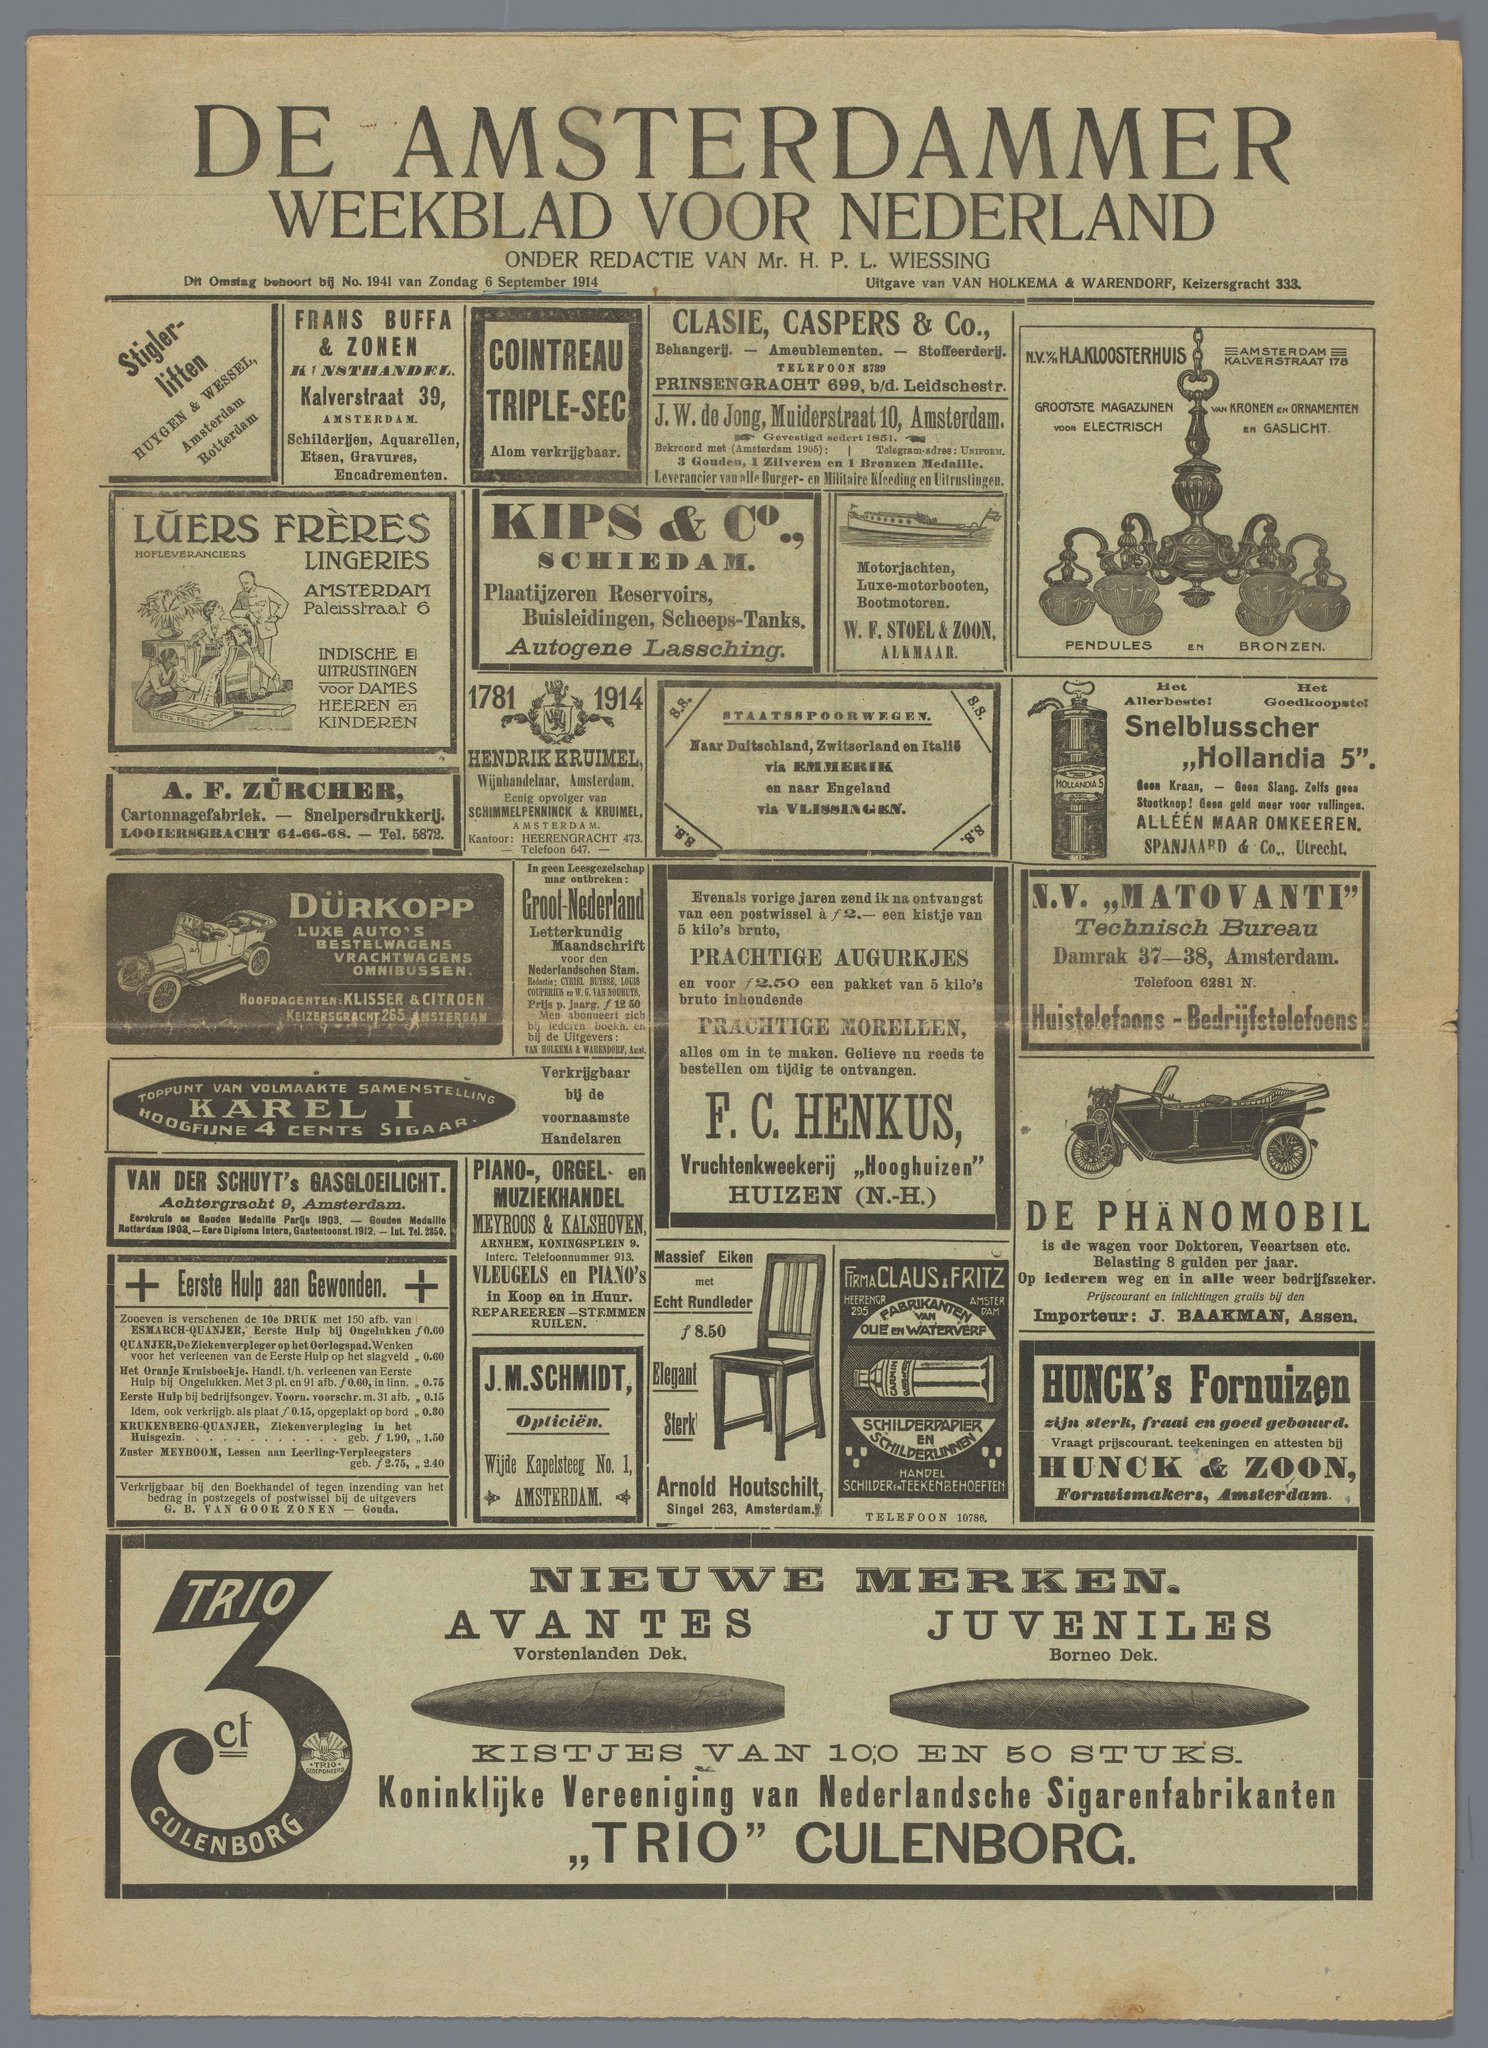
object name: magazine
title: De Amsterdammer; weekblad voor Nederland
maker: henri pierre leonard wiessing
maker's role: journalist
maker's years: 1878-1961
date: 1914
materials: paper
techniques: printing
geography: amsterdam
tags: netherlands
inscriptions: date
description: Nummer van een tijdschrift (no. 1941 van 'De Amsterdammer'), 8 genummerde pp in groene papieren omslag (van 4 pp) met vnl advertenties. Gedateerd; l.b.: Zondag 6 September 1914.